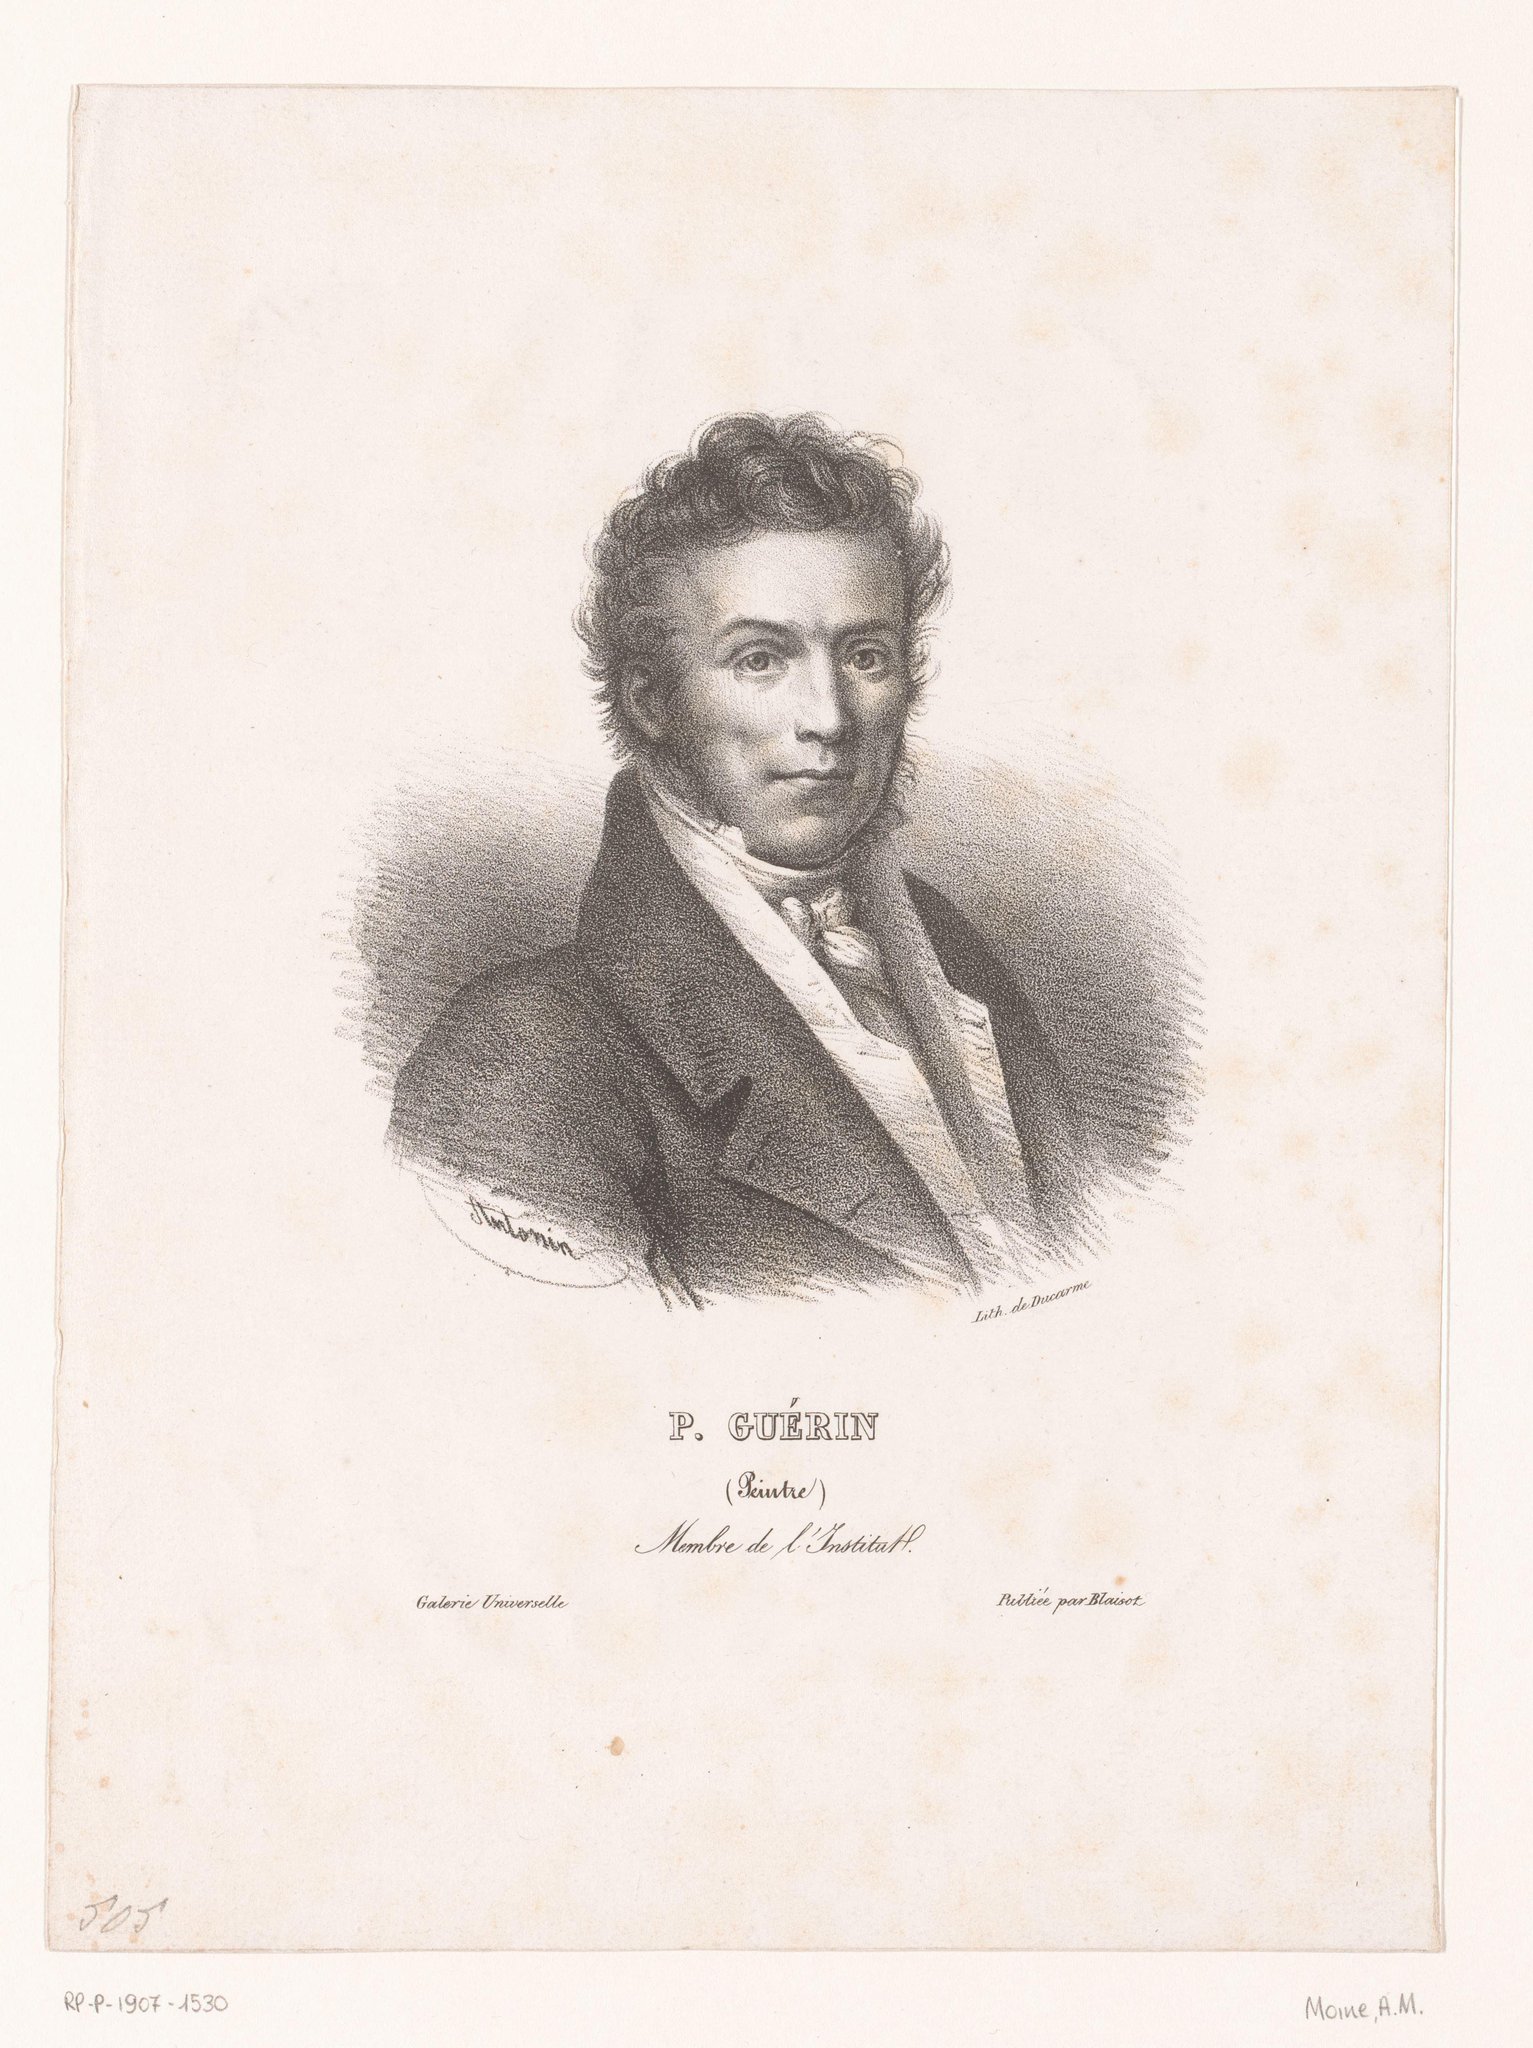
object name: print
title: Portrettengalerij van Blaisot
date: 1820-1829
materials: paper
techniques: lithograph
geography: paris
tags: paris, rome, painter, print maker, draughtsman, pierre narcisse guérin, historical persons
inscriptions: collector's mark: Lugt 2228